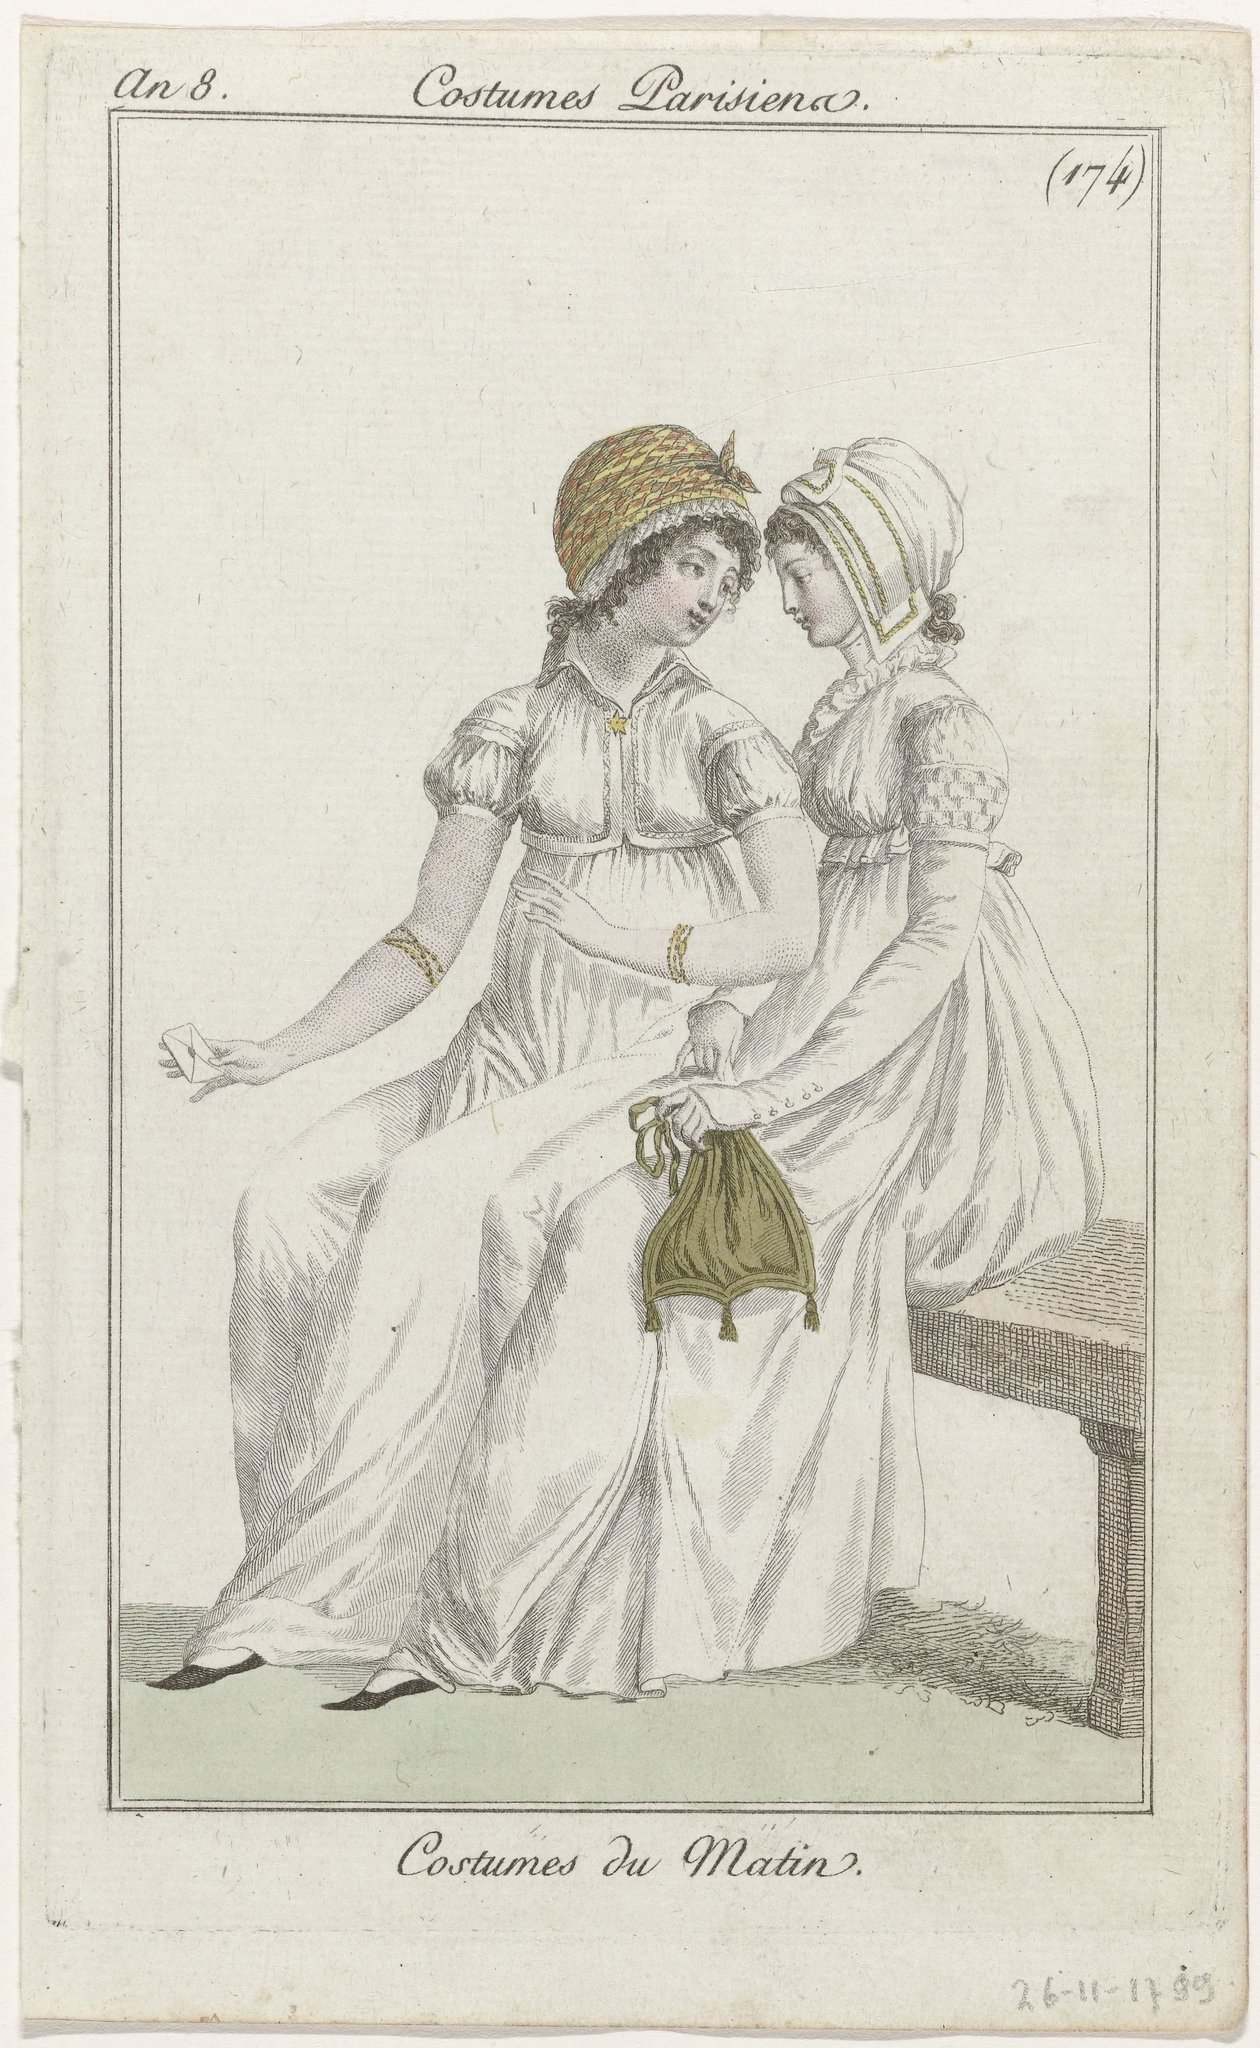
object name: fashion print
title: Journal des Dames et des Modes, Costume Parisien, 26 novembre 1799, An 8, (174) : Costumes du Matin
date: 1799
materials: paper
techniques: engraving, hand coloring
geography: paris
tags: bench, head-gear: turban (+ women's clothes), dress, gown: morning dress (+ women's clothes), bag (reticule) (+ women's clothes), clothing for the upper part of the body (spencer) (+ women's clothes), head-gear: cap (+ women's clothes), fashion plates, shoes, sandals (+ women's clothes), letter, envelope, bracelet, wristlet (+ women's clothes)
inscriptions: caption: ‘Costumes du Matin.’, title: ‘Costumes Parisiens.’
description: Twee vrouwen zittend op een bankje, van wie één met brief in de hand. Zij zijn gekleed in ochtend-ensembles. Links: 'canezou' op een japon met korte pofmouwen. Accessoires: tulband, stervormige broche(?), armbanden om beide armen, platte schoen met puntige neus. Rechts: spencer op een japon. Accessoires: muts, reticule met drie kwasten, platte schoen met puntige neus. De prent maakt deel uit van het modetijdschrift Journal des Dames et des Modes, uitgegeven door Pierre de la Mésangère, Parijs, 1797-1839.